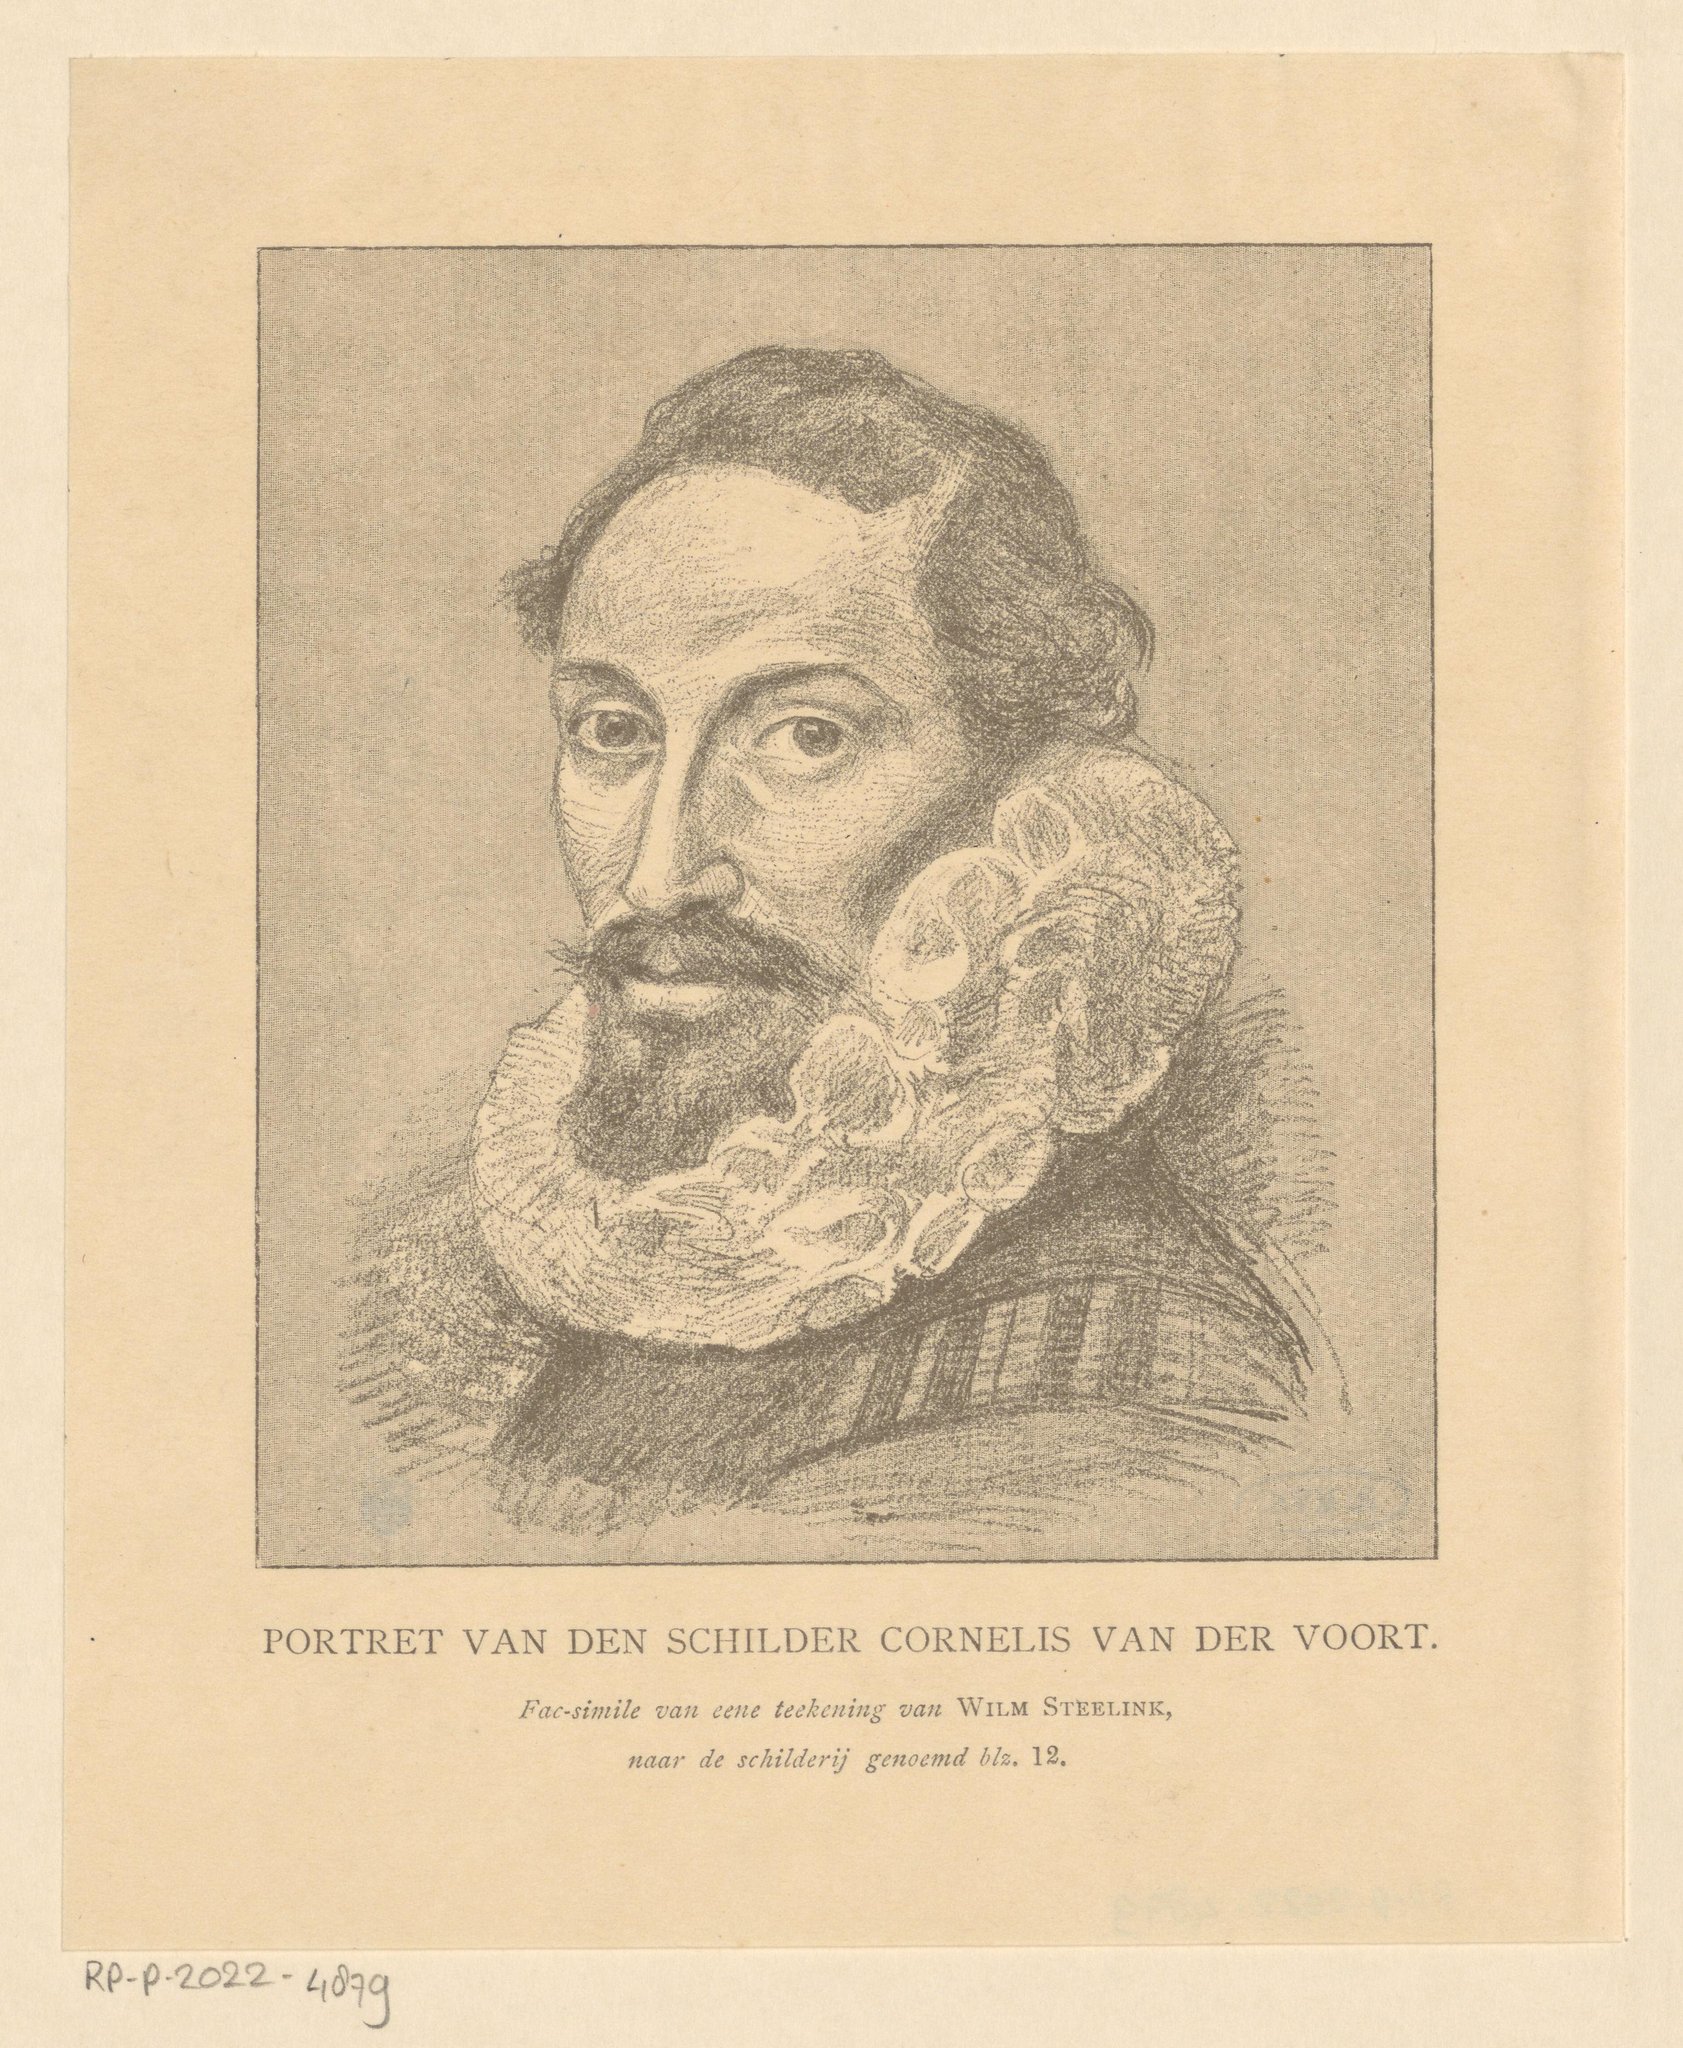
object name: photomechanical print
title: Portret van Cornelis van der Voort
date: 1887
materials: paper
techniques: photomechanical printing process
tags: antwerp, painter, draughtsman, cornelis van der voort, historical persons, portrait, self-portrait of painter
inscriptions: collector's mark: Lugt 2228, collector's mark: Lugt 2760